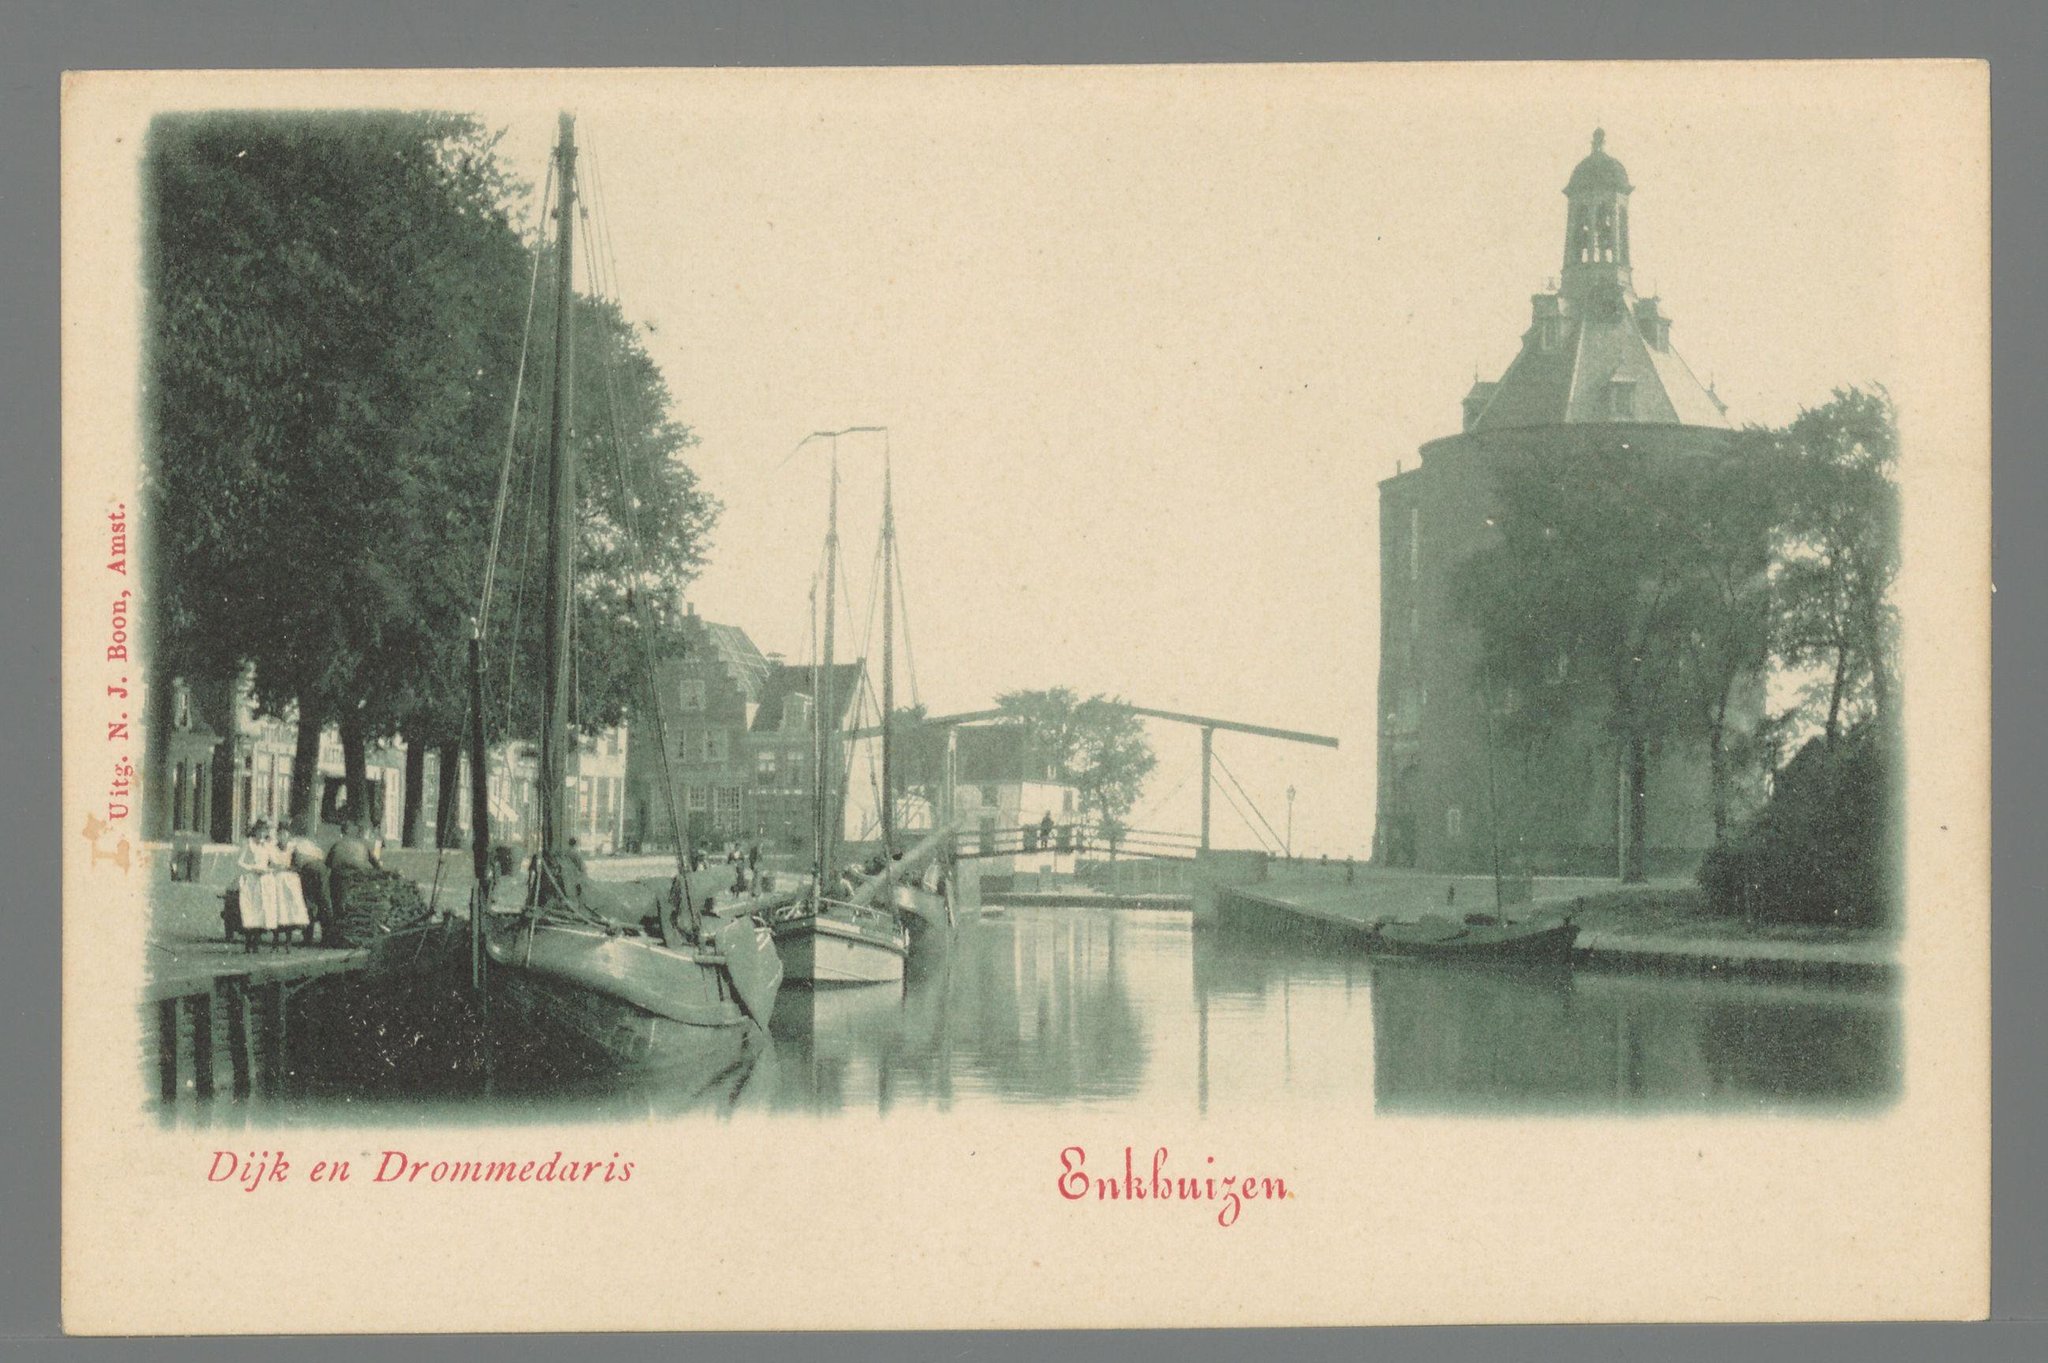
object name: photomechanical print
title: Dijk en Drommedaris. Enkhuizen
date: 1892-1905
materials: cardboard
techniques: photograph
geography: amsterdam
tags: city-view, and landscape with man-made constructions, sailing-ship, sailing-boat, bridge in city across river, canal, etc., city-gate, enkhuizen